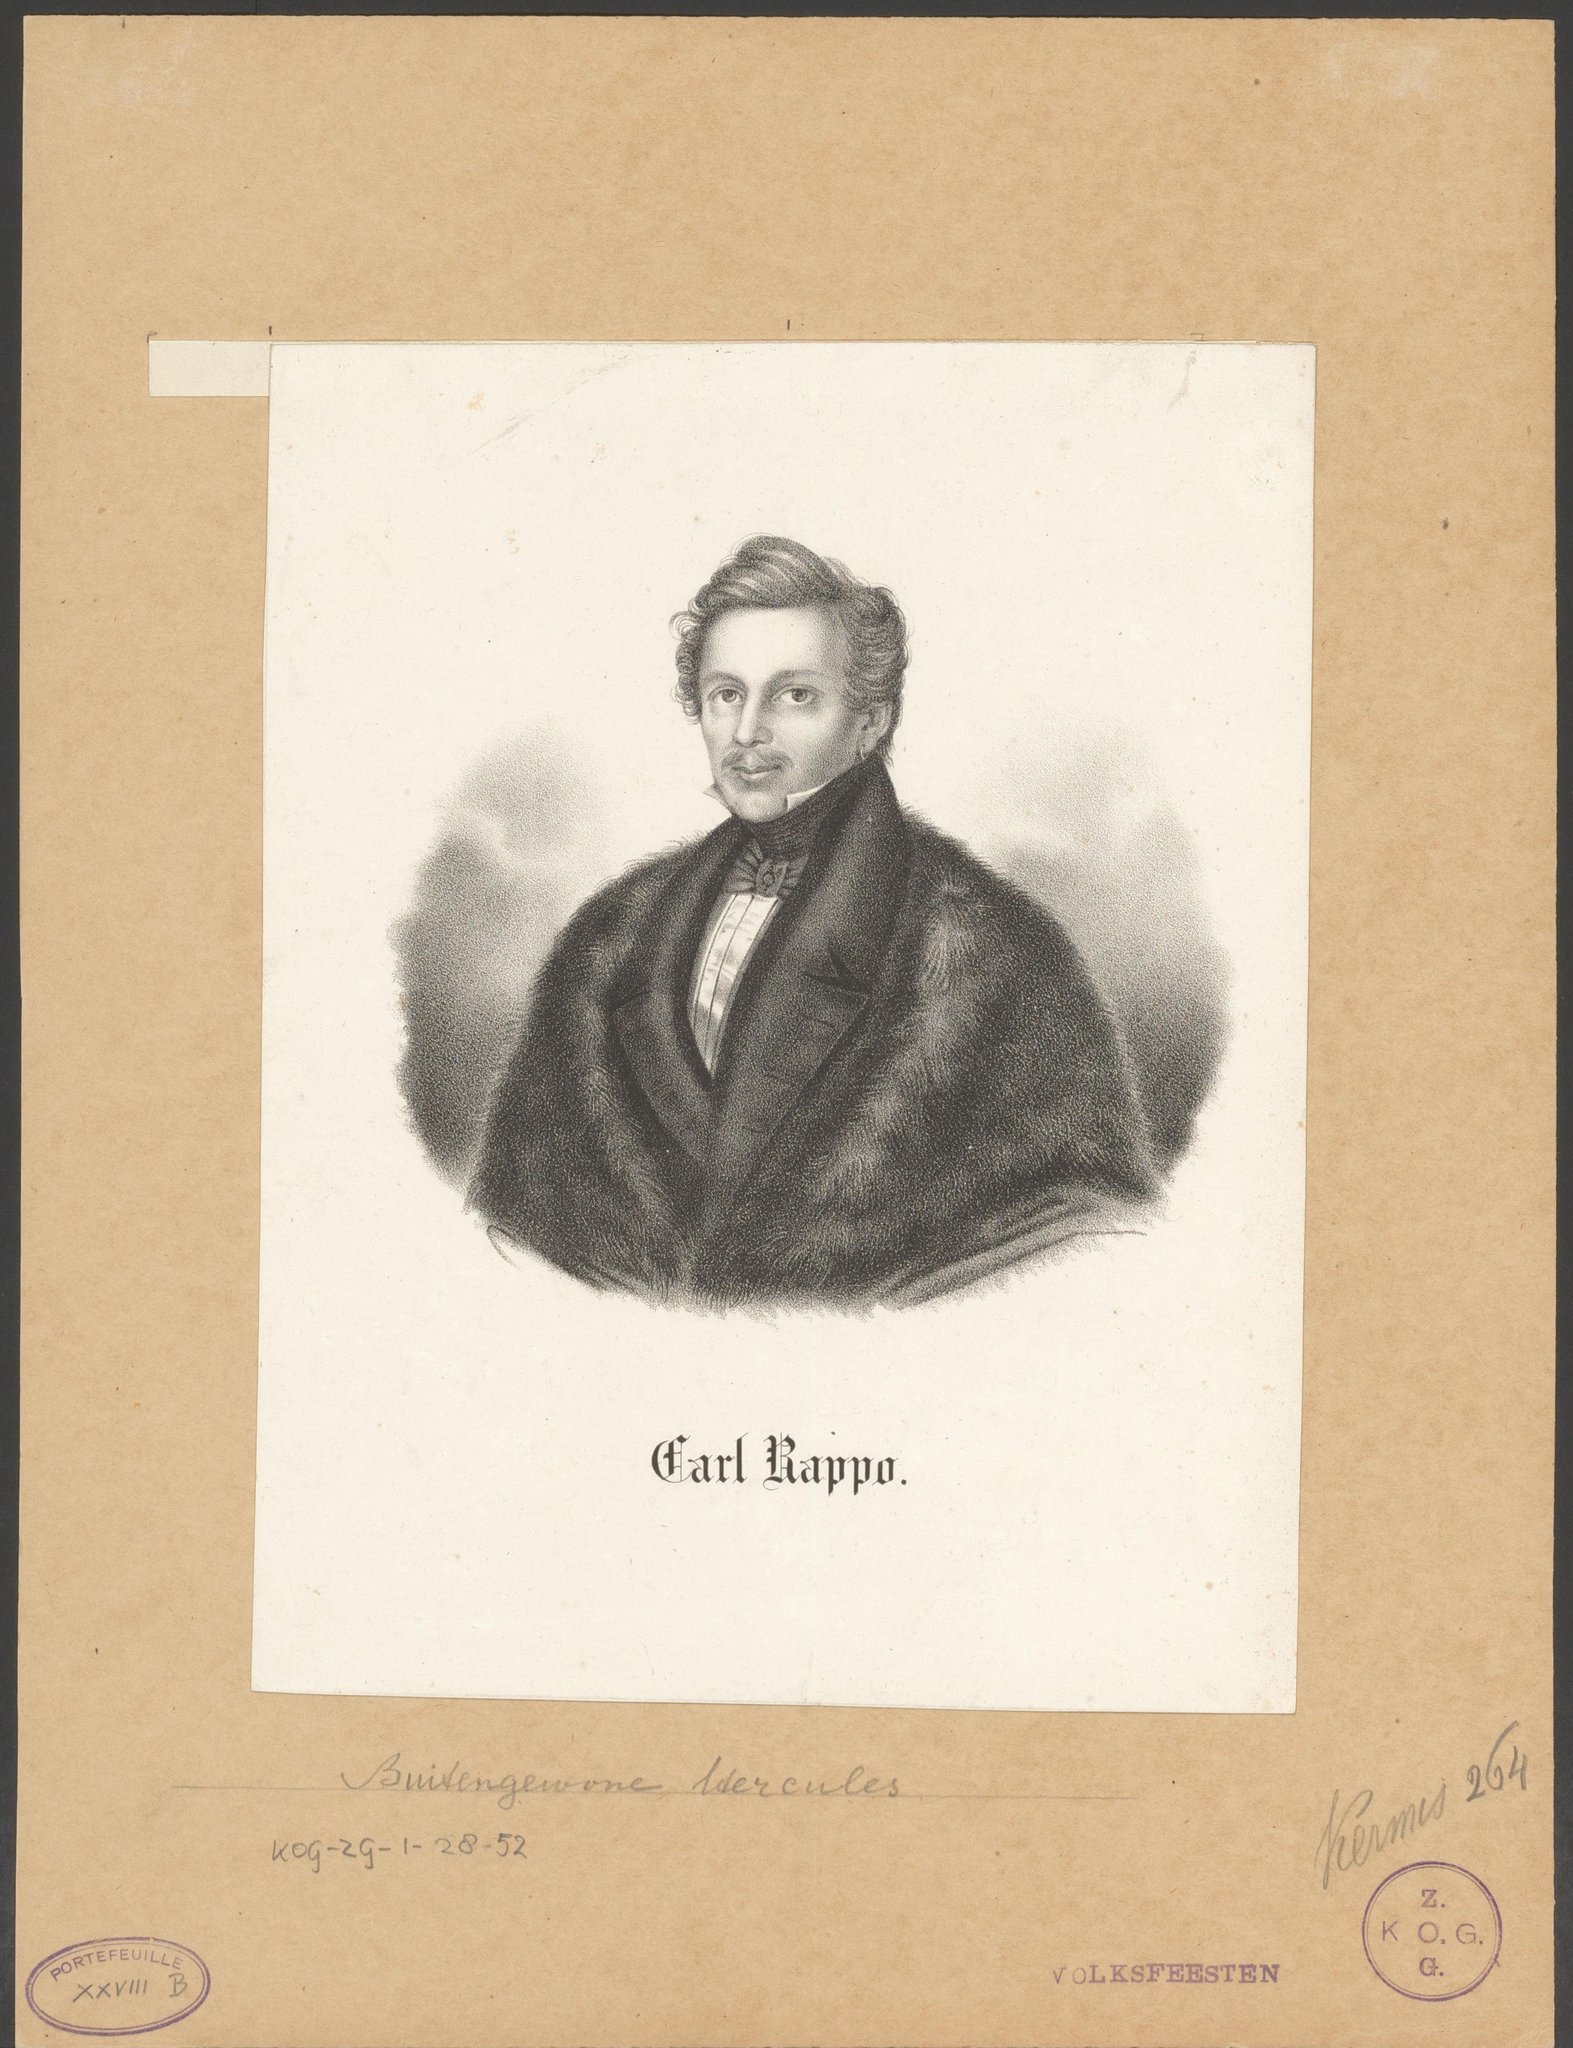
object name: print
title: Portret van Charles Rappo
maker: Anonymous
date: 1815-1854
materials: paper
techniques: lithograph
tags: vienna, historical persons, acrobat ~ circus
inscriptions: stamp, collector's mark: Lugt 1641, stamp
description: Circusartiest Charles Rappo stond bekend als de Duitsche Hercules. Onderwerpsrubrieken binnen de Atlas Zeden en Gewoonten: Zeden en Gewoonten in Engeren Zin. Volksleven. Volksfeesten. Circusmenschen, dierentemmers, acrobaten, goochelaars, en dergelijken.